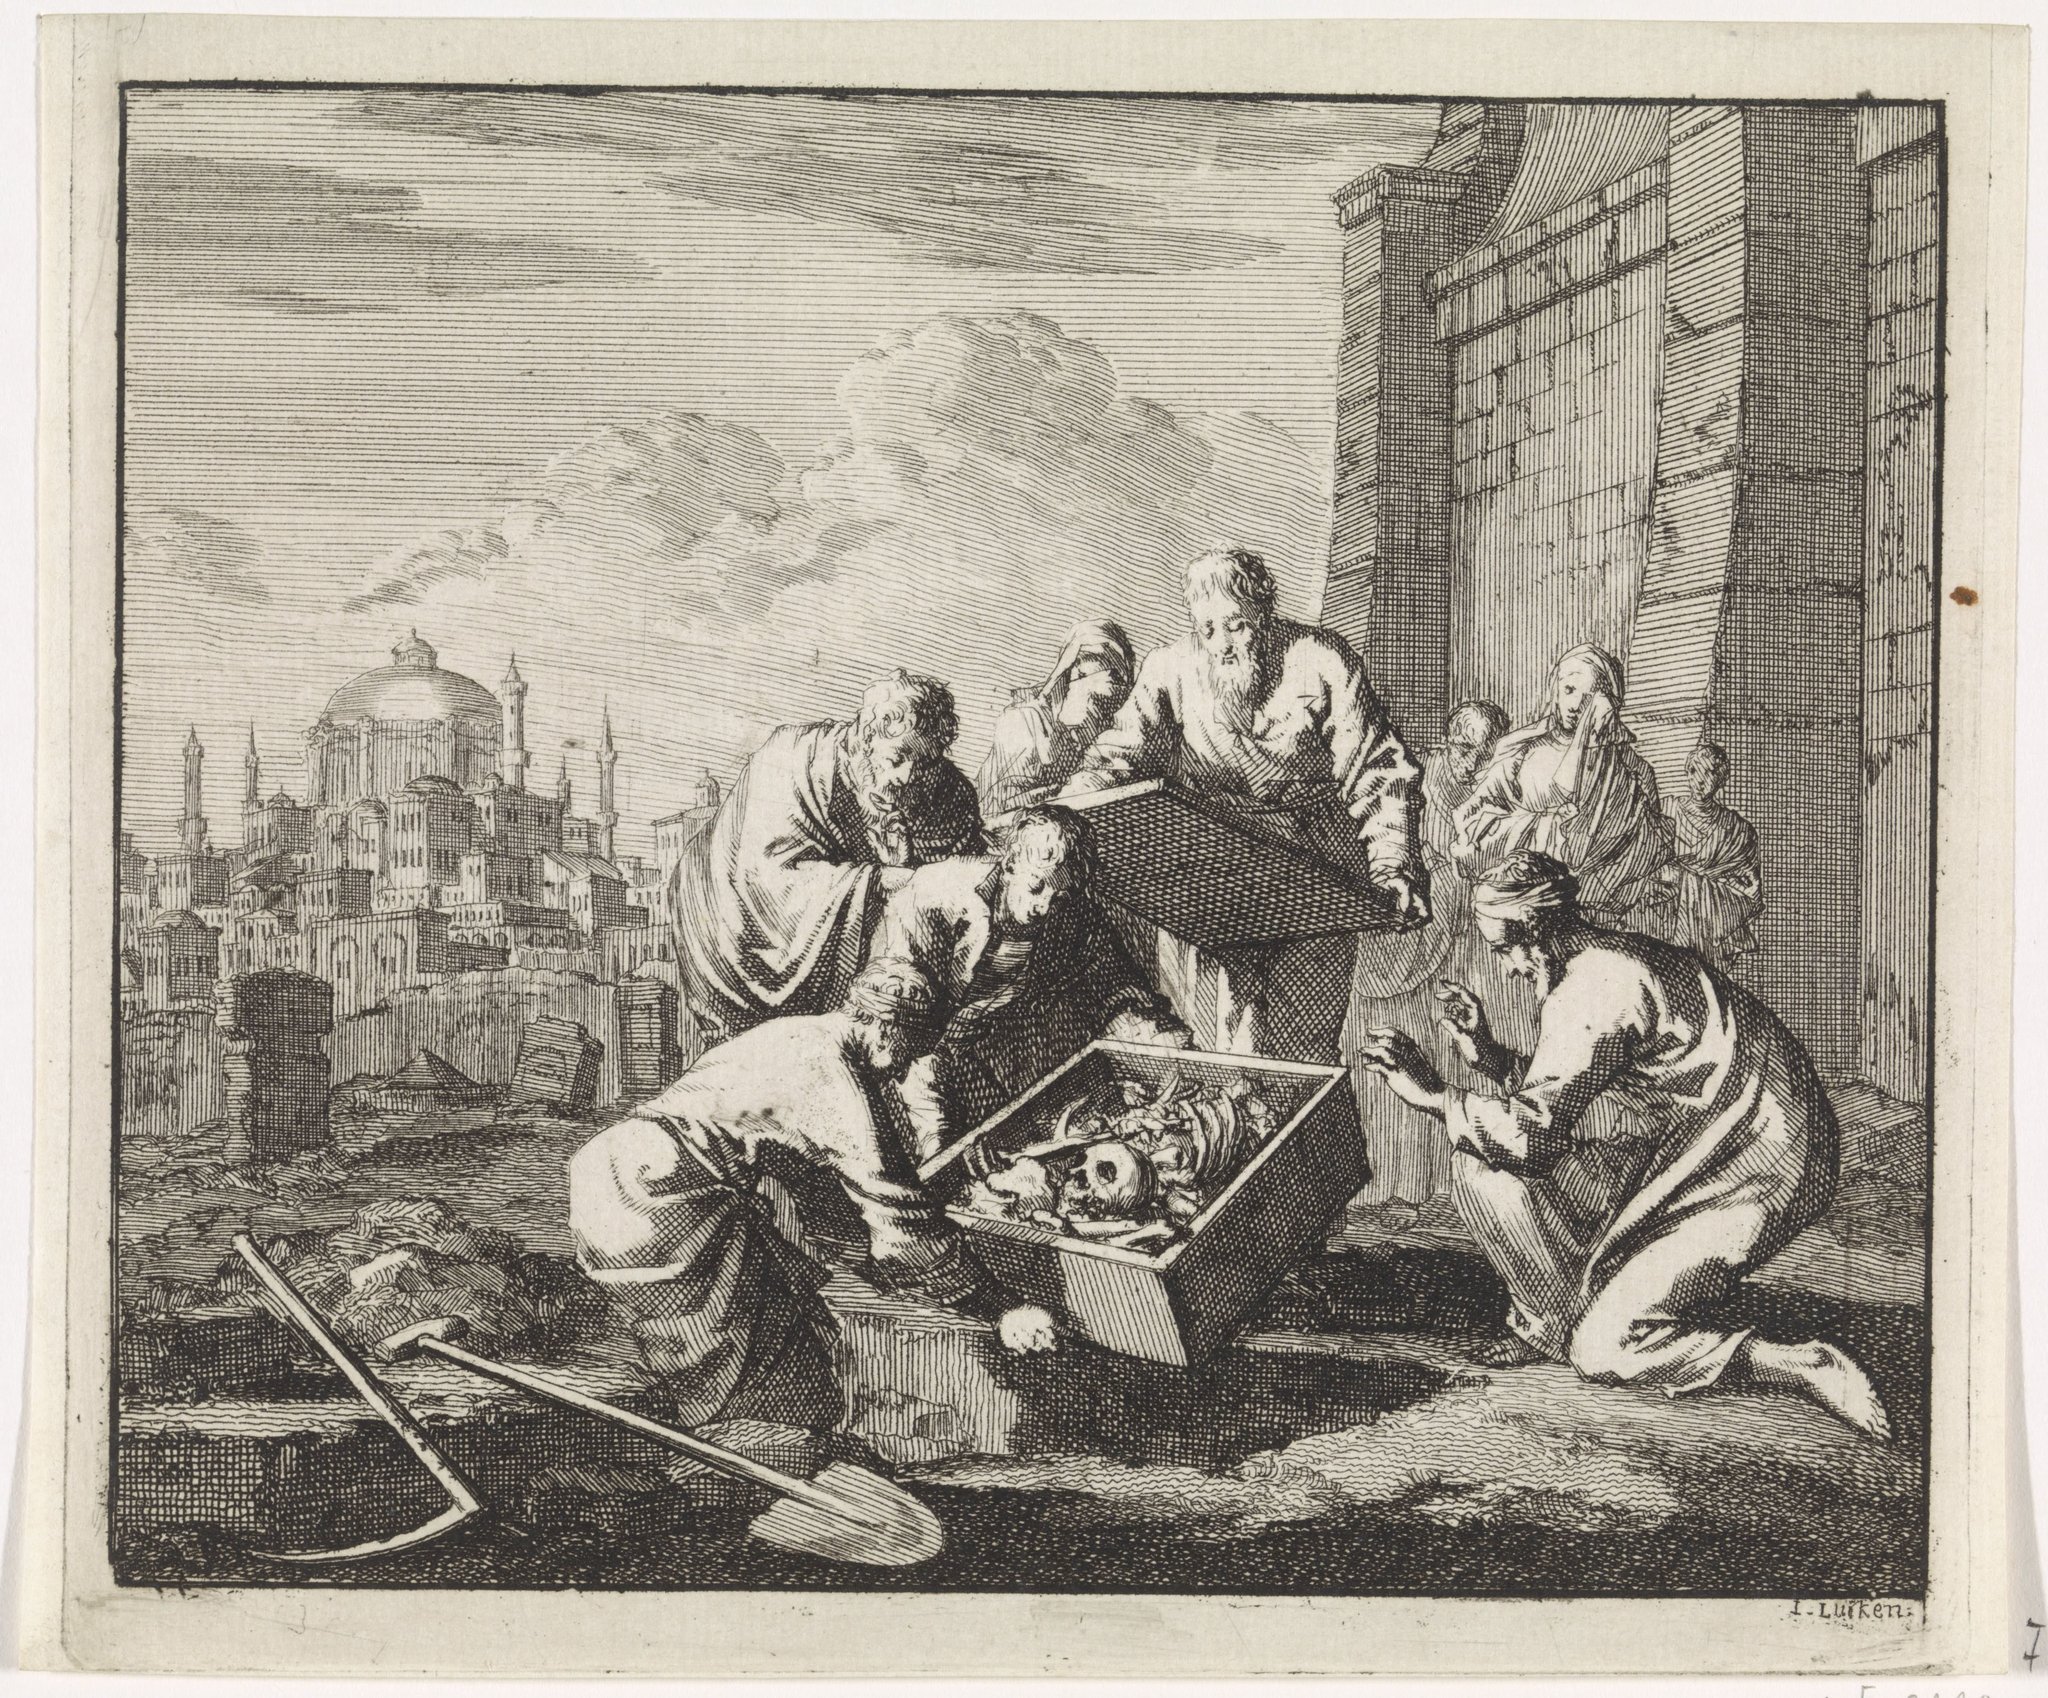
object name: print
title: Begraving van de beenderen van de H. Johannes Chrysostomus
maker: jan luyken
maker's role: draughtsman, print maker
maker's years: 1649-1712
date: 1701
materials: paper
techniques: etching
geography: amsterdam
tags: burial, the early christian churches, e.g. armenians, copts, syrians, the archbishop of constantinople, john chrysostom; possible attributes: beehive, dove - finding, transportation of relics of male saint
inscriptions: collector's mark: Lugt 2228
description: Proefdruk van een boekillustratie Arnold, Godfried. Waare afbeelding der eerste christenen. Amsterdam: Jacobus van Hardenberg, Barent Visscher en Jacobus van Nieuweveen, 1700, dl. 2.